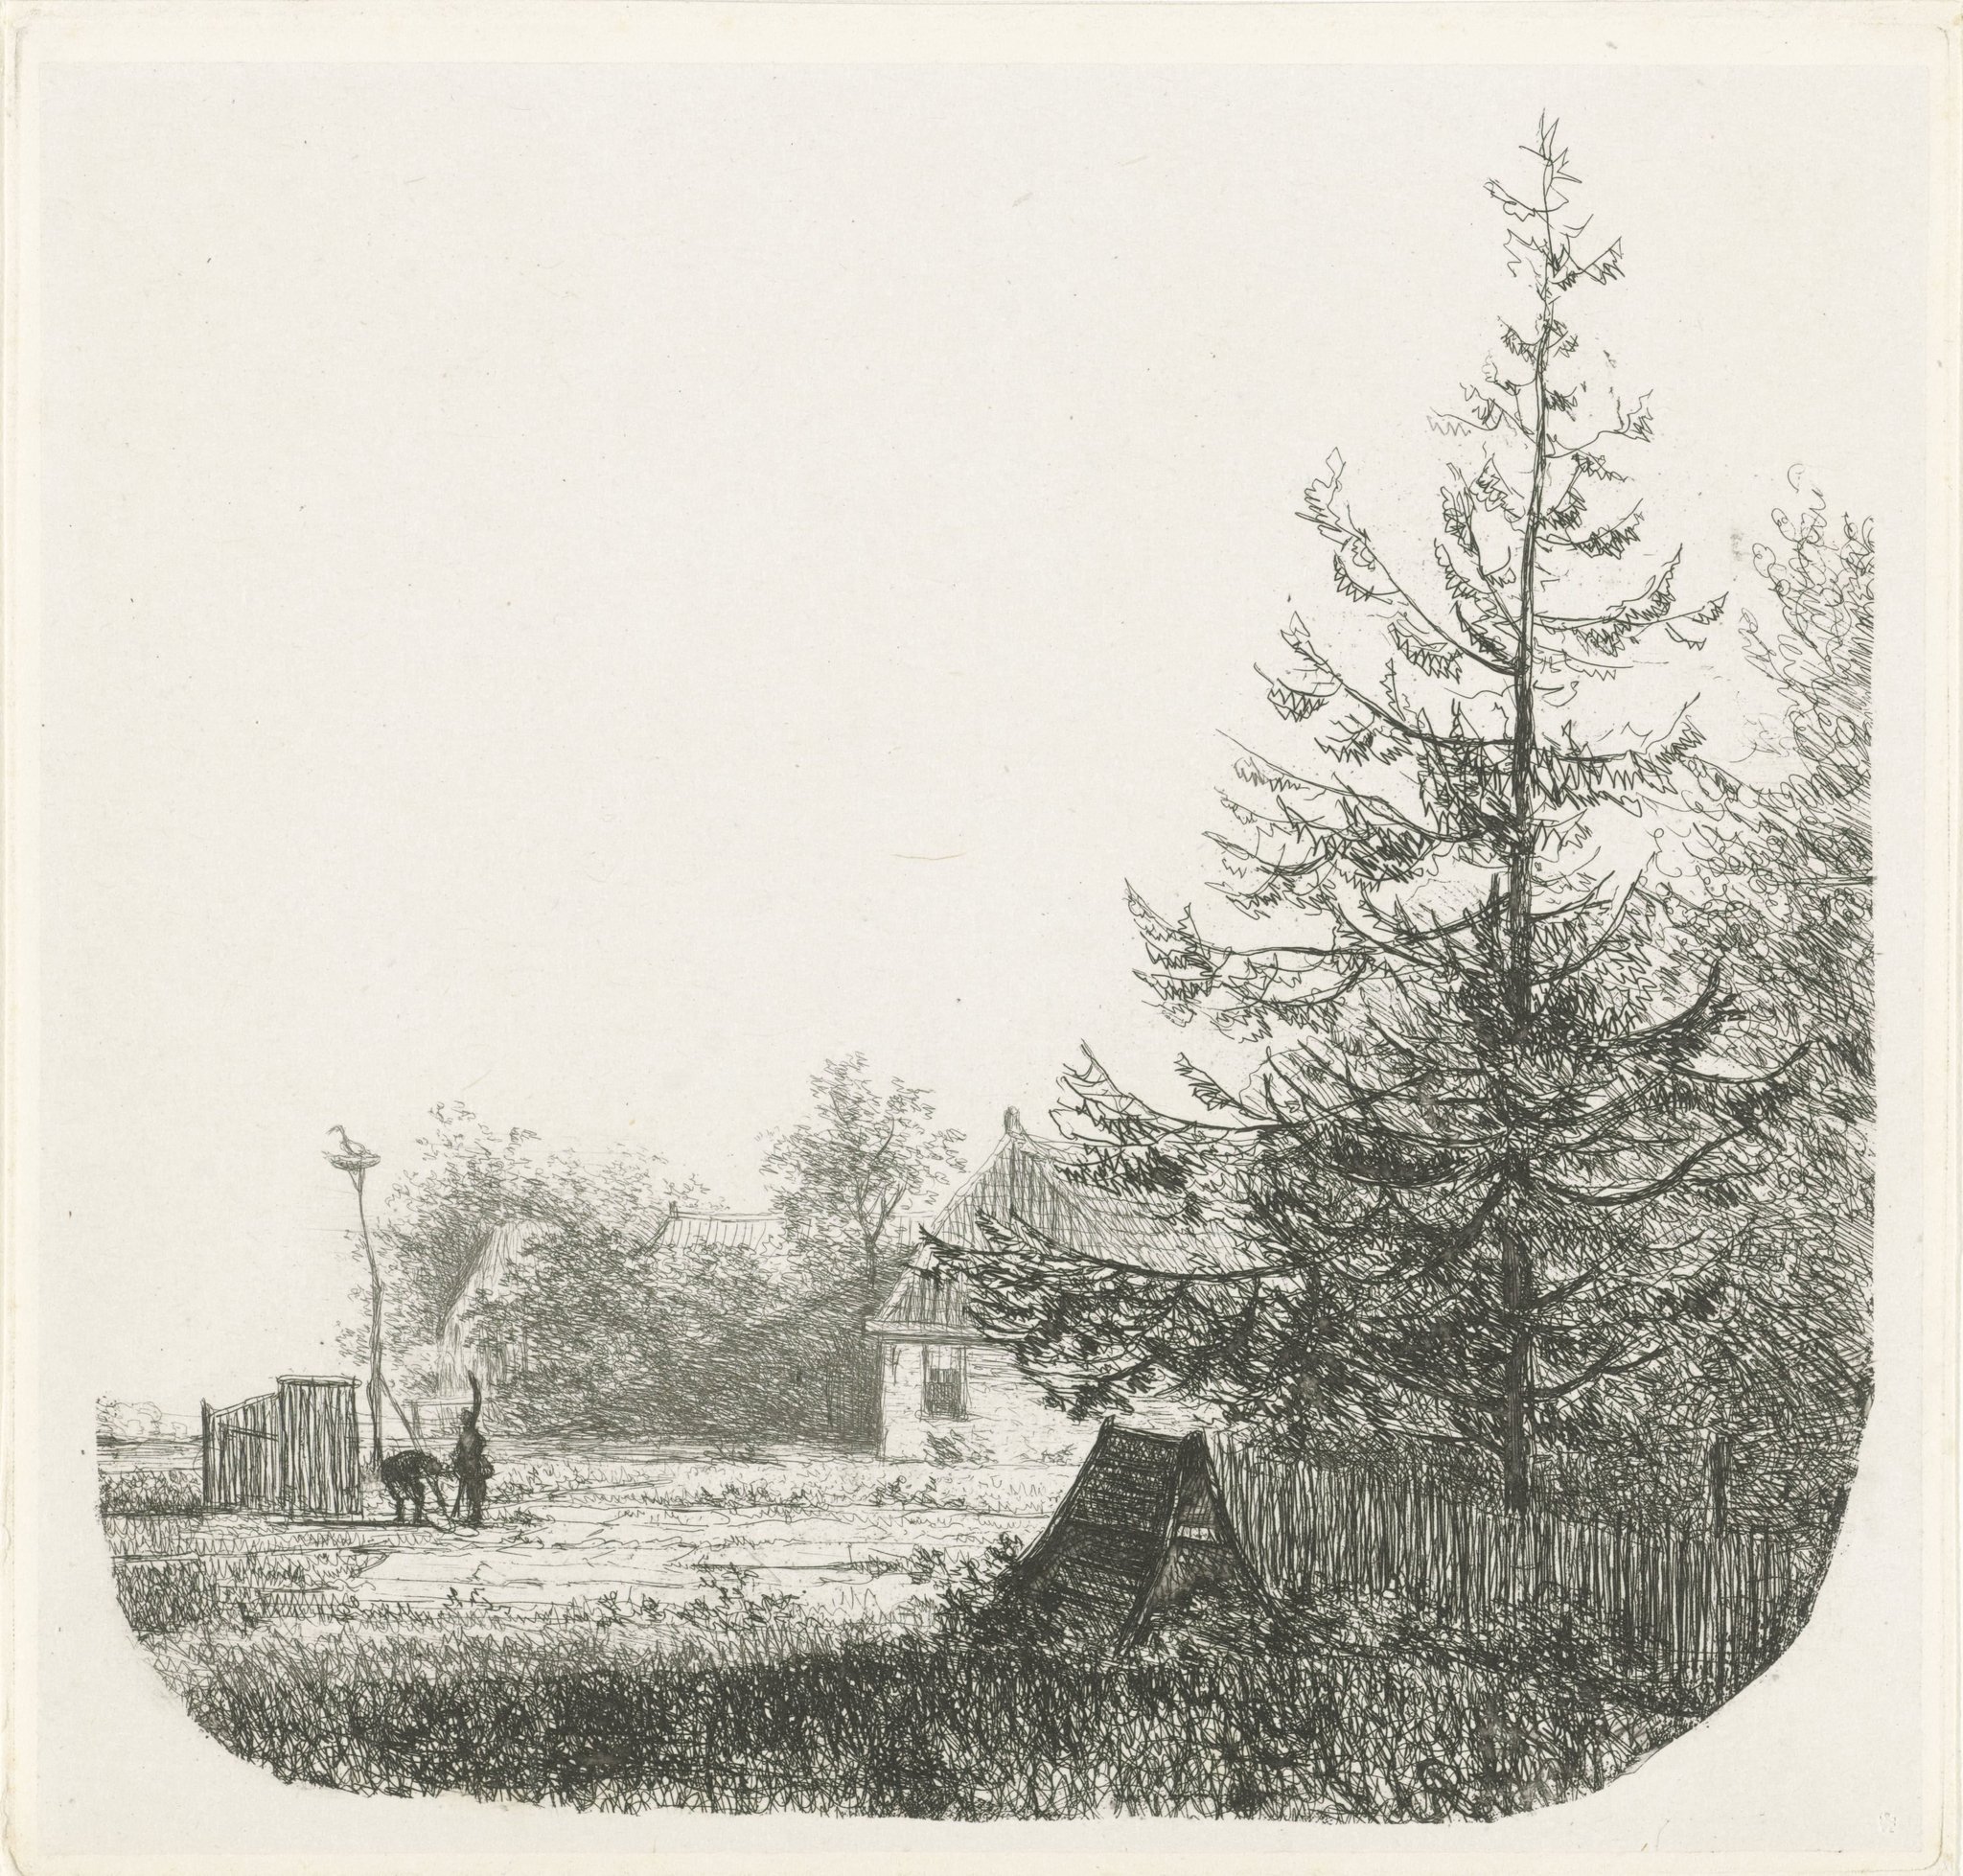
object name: print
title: Boomrijk landschap met een ooievaarsnest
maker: nicolaas johannes roosenboom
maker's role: draughtsman, print maker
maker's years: 1805-1880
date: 1825-1880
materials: paper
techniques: drypoint, etching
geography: europe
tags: shore-birds and wading-birds: stork (+ nest, den, burrow), groups of trees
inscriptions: collector's mark: Lugt 2228, collector's mark: Lugt 2508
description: Gezicht op een boomrijk landschap met links twee mannen bij een ooievaarsnest. Op de achtergrond enkele huizen.